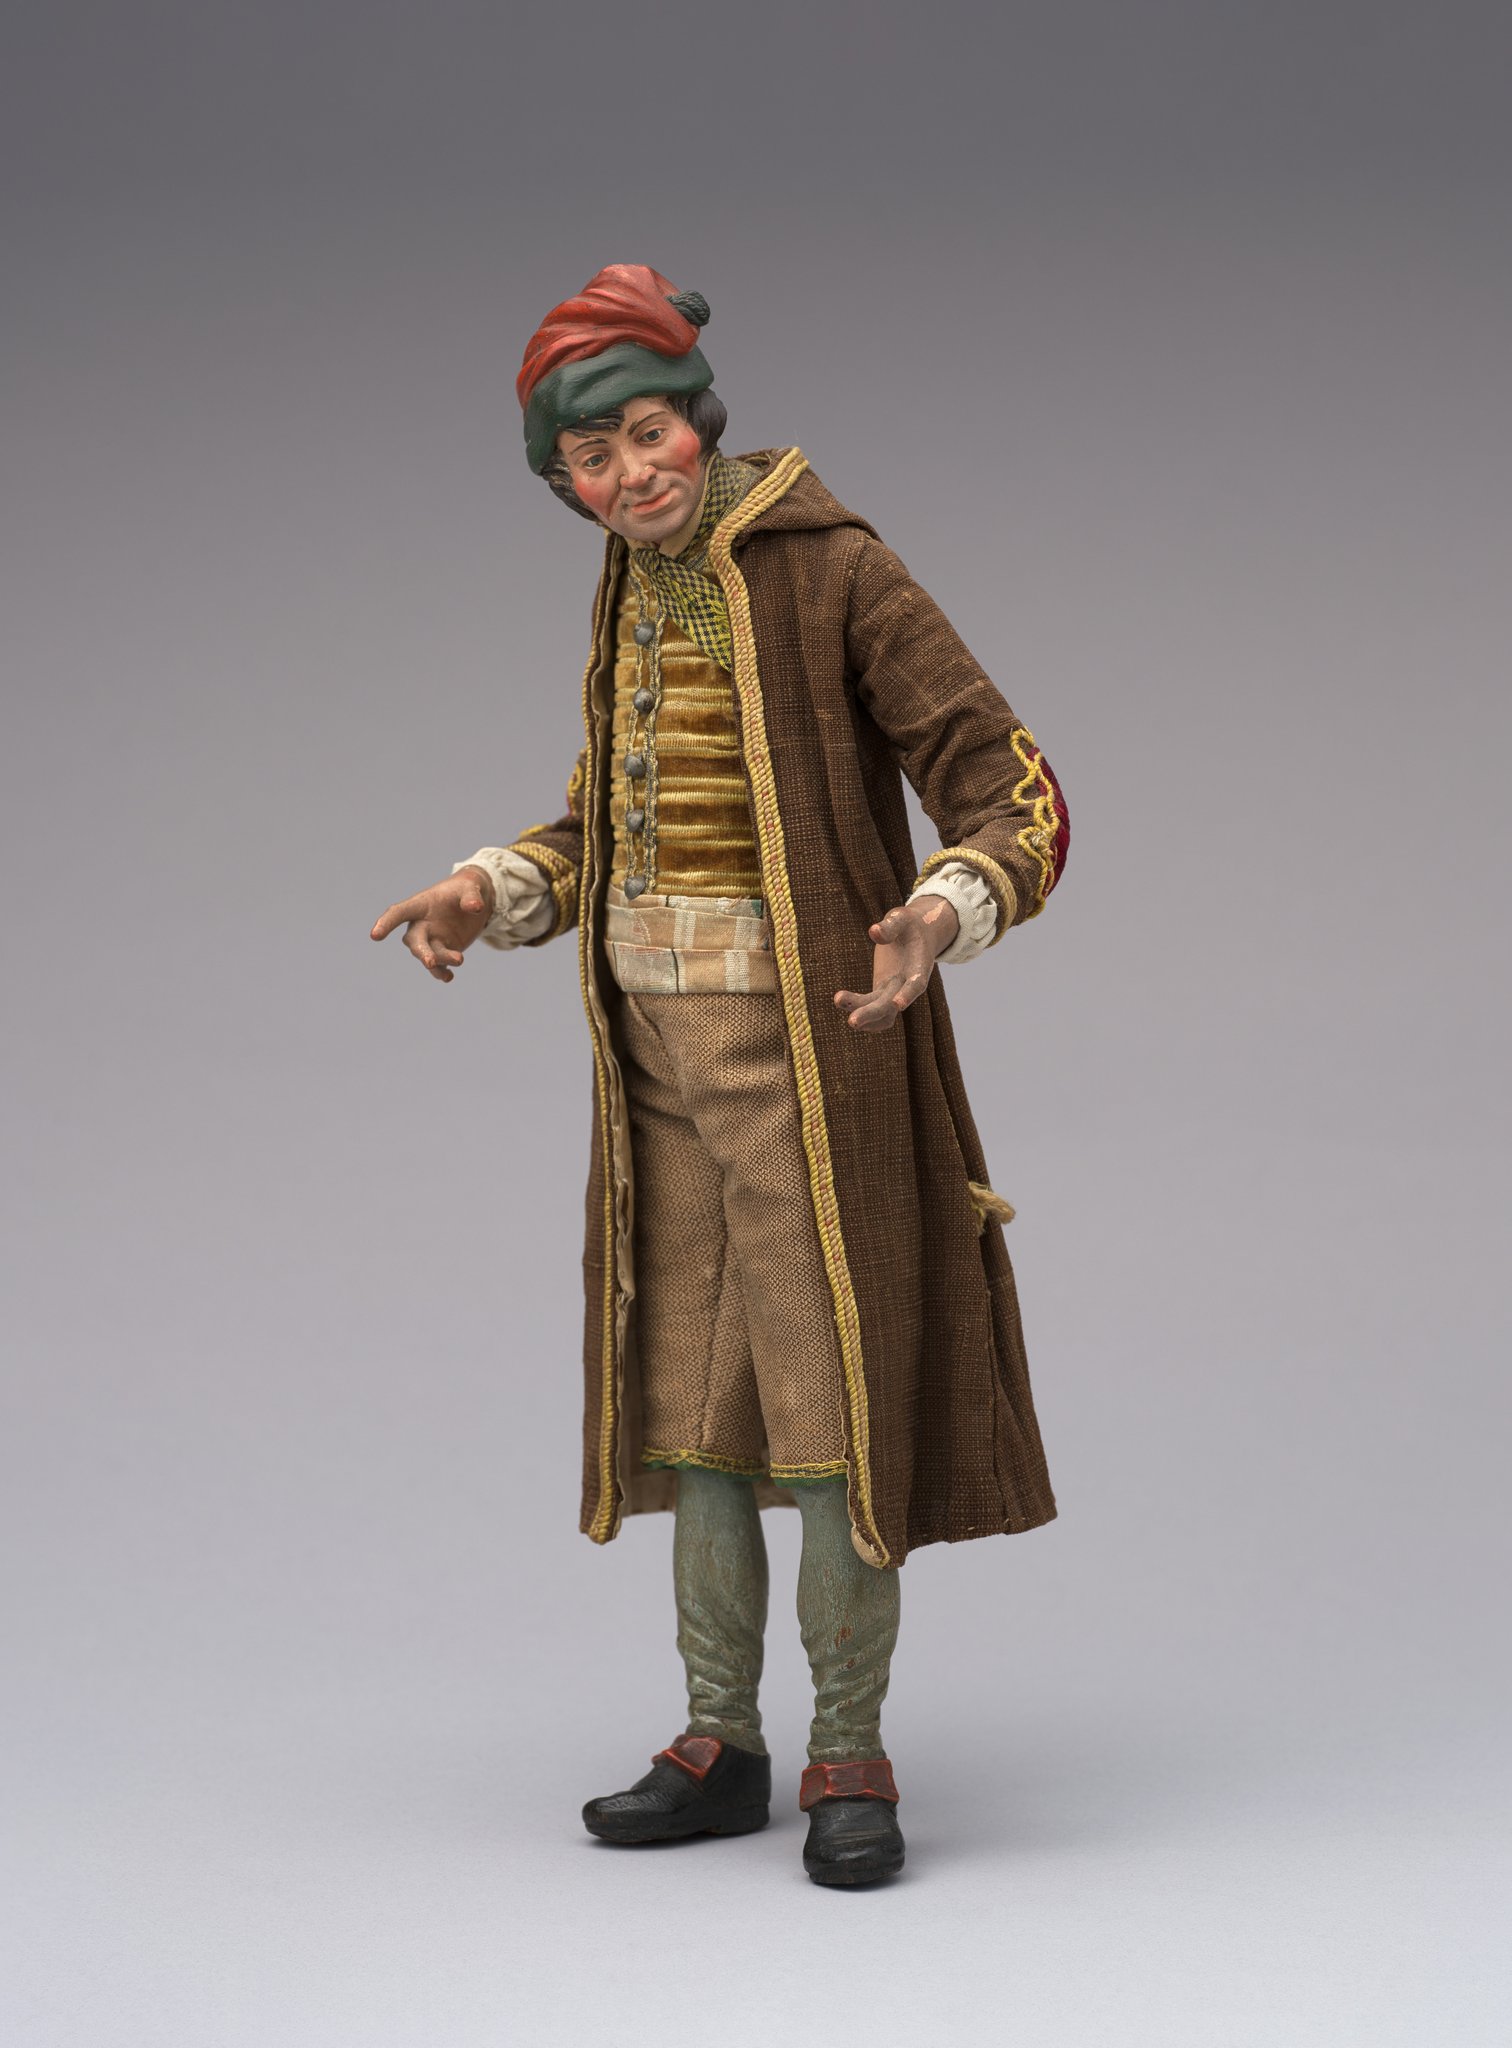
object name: crèche figure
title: Chestnut vendor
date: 1701-1800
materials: cotton, metal, silk, terracotta, fiber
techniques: polychrome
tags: men